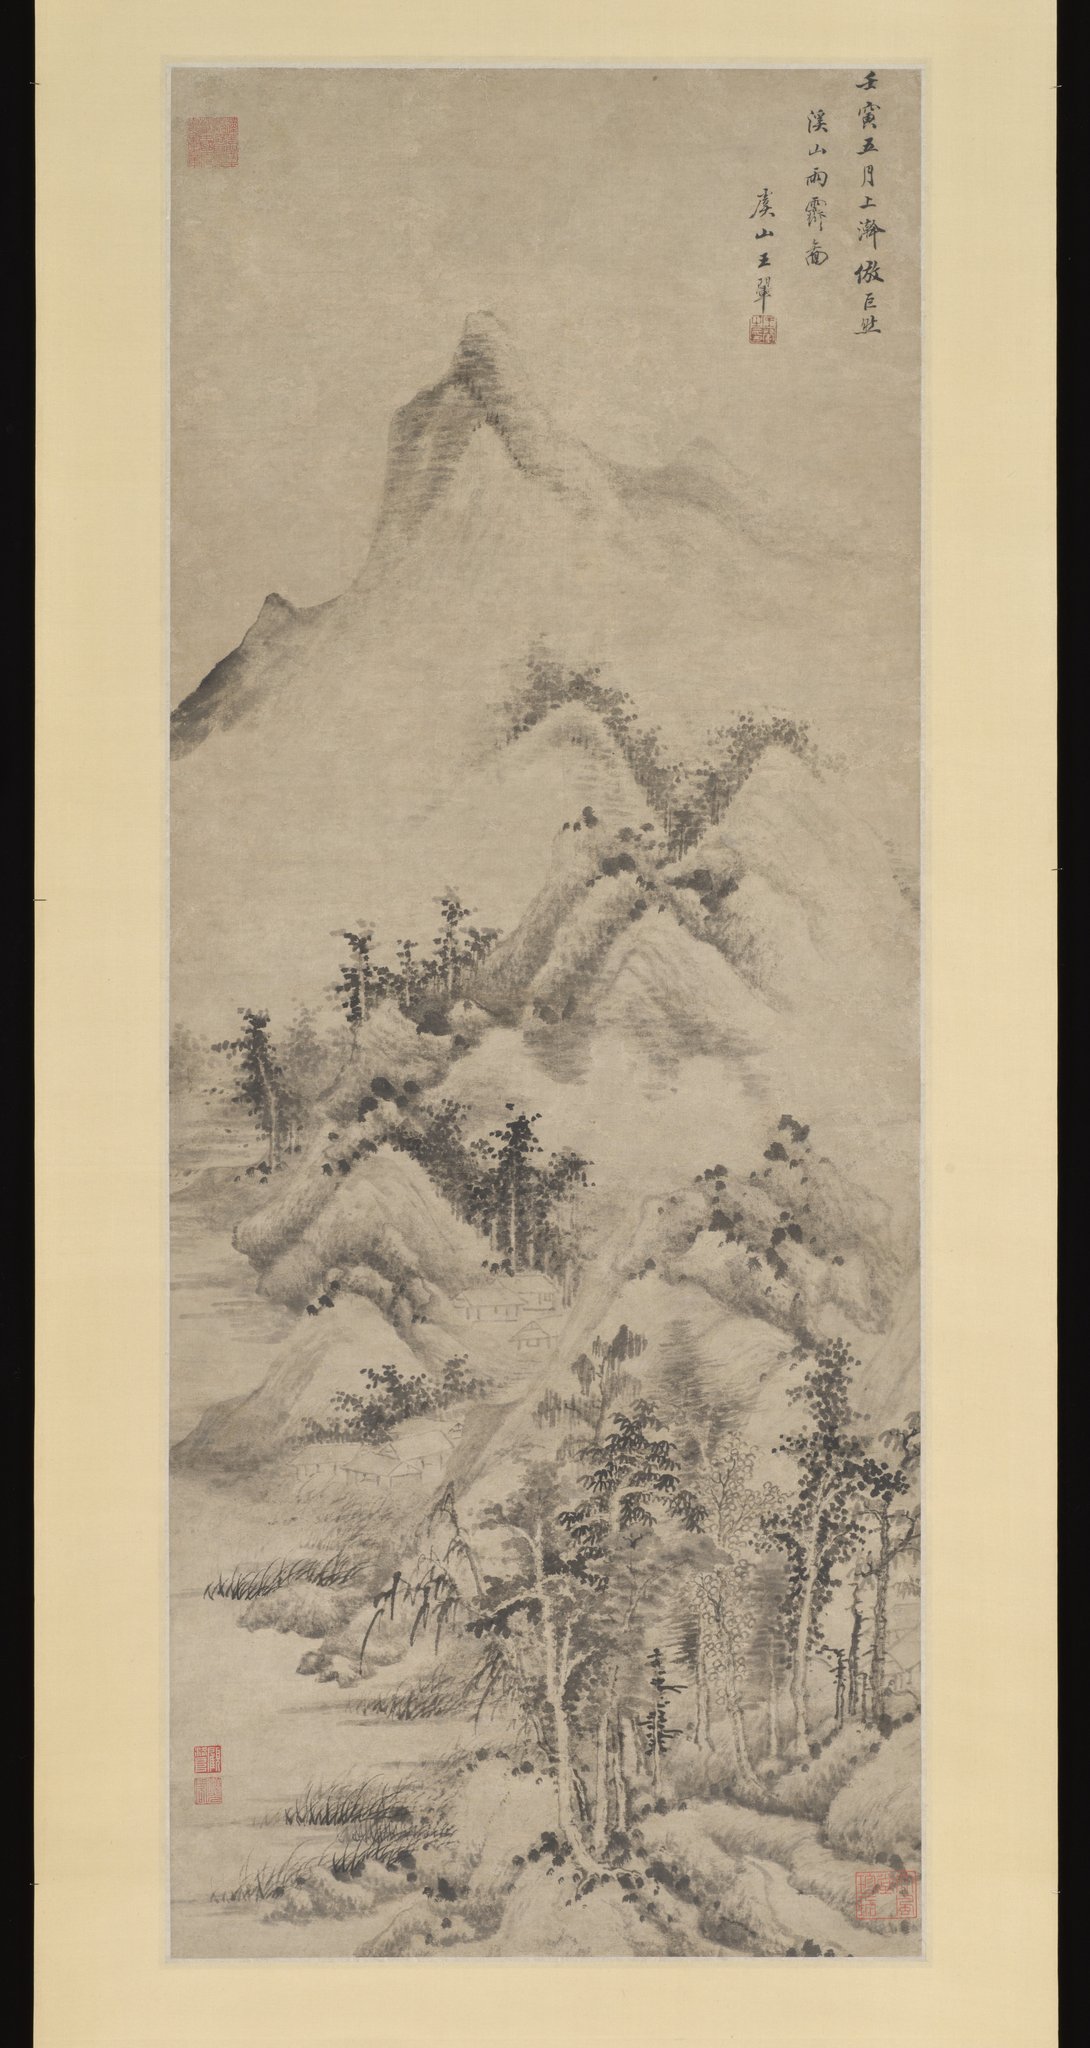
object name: hanging scroll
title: Clearing after Rain over Streams and Mountains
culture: chinese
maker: wang hui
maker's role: artist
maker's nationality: chinese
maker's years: 1632-1717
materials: ink, paper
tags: mountains,trees